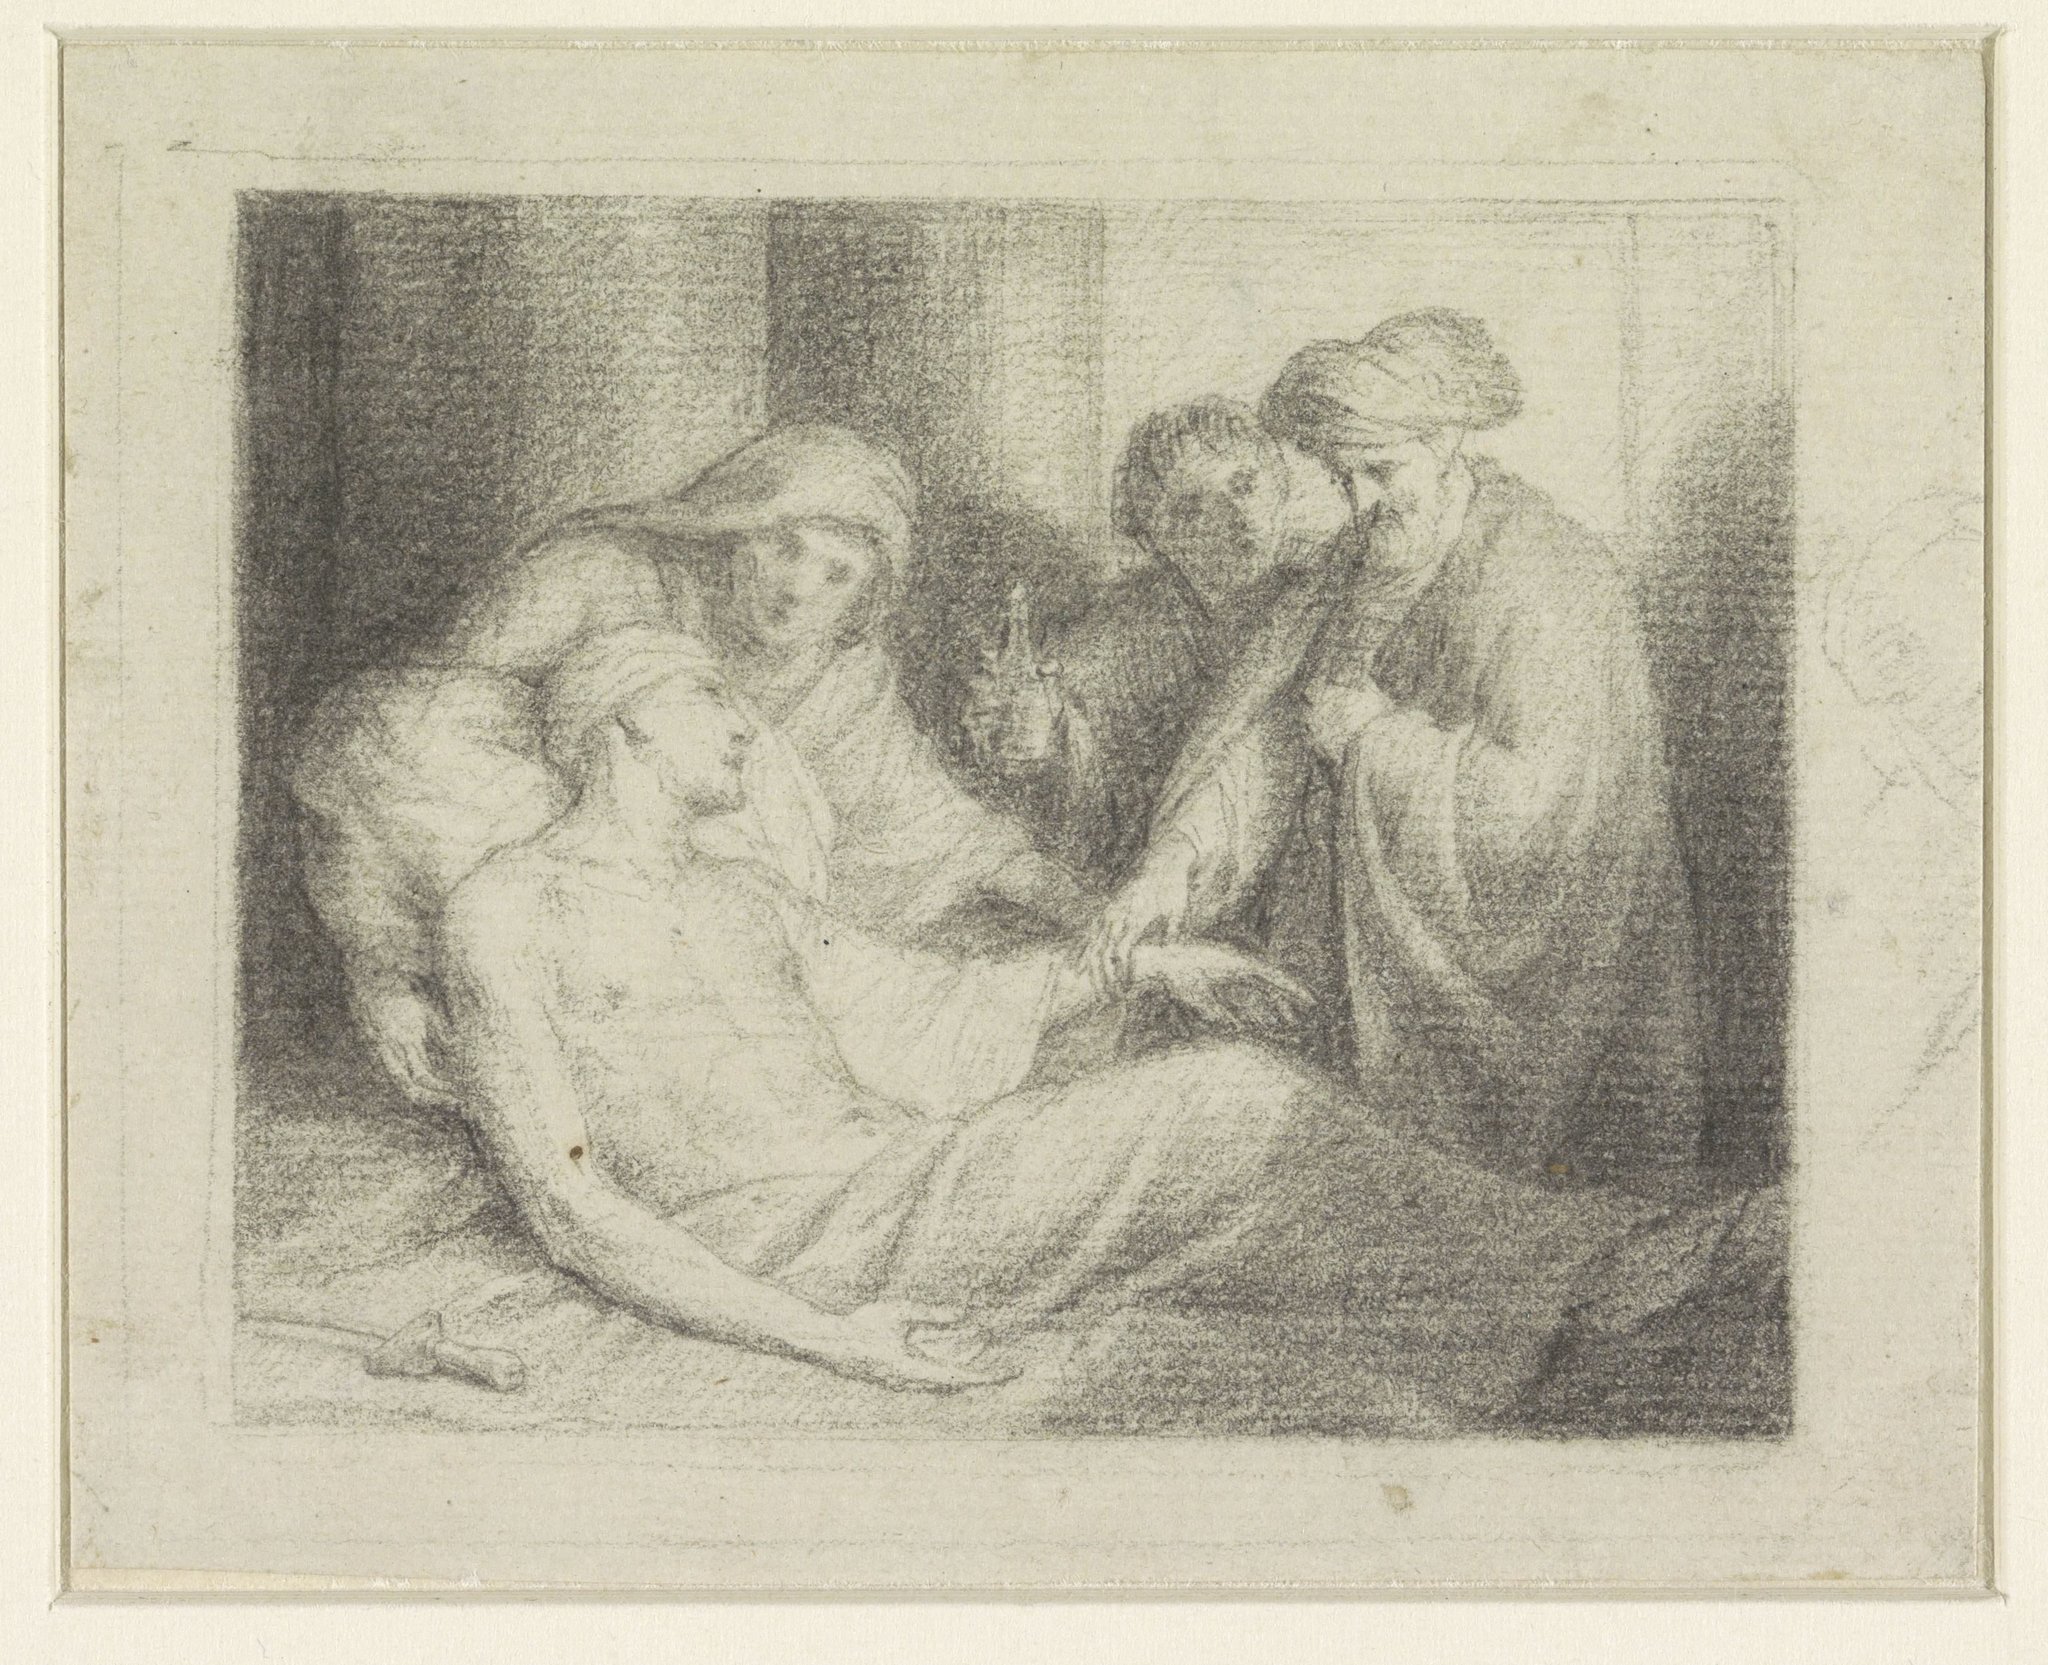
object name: design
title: Ontwerp voor vignet van het Geneeskundig Genootschap te Antwerpen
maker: andreas bernardus de quertenmont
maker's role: draughtsman, print maker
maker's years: 1750-1835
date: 1760-1835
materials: paper, pencil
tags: feeling pulse or heart-beat, nursing, tending the sick